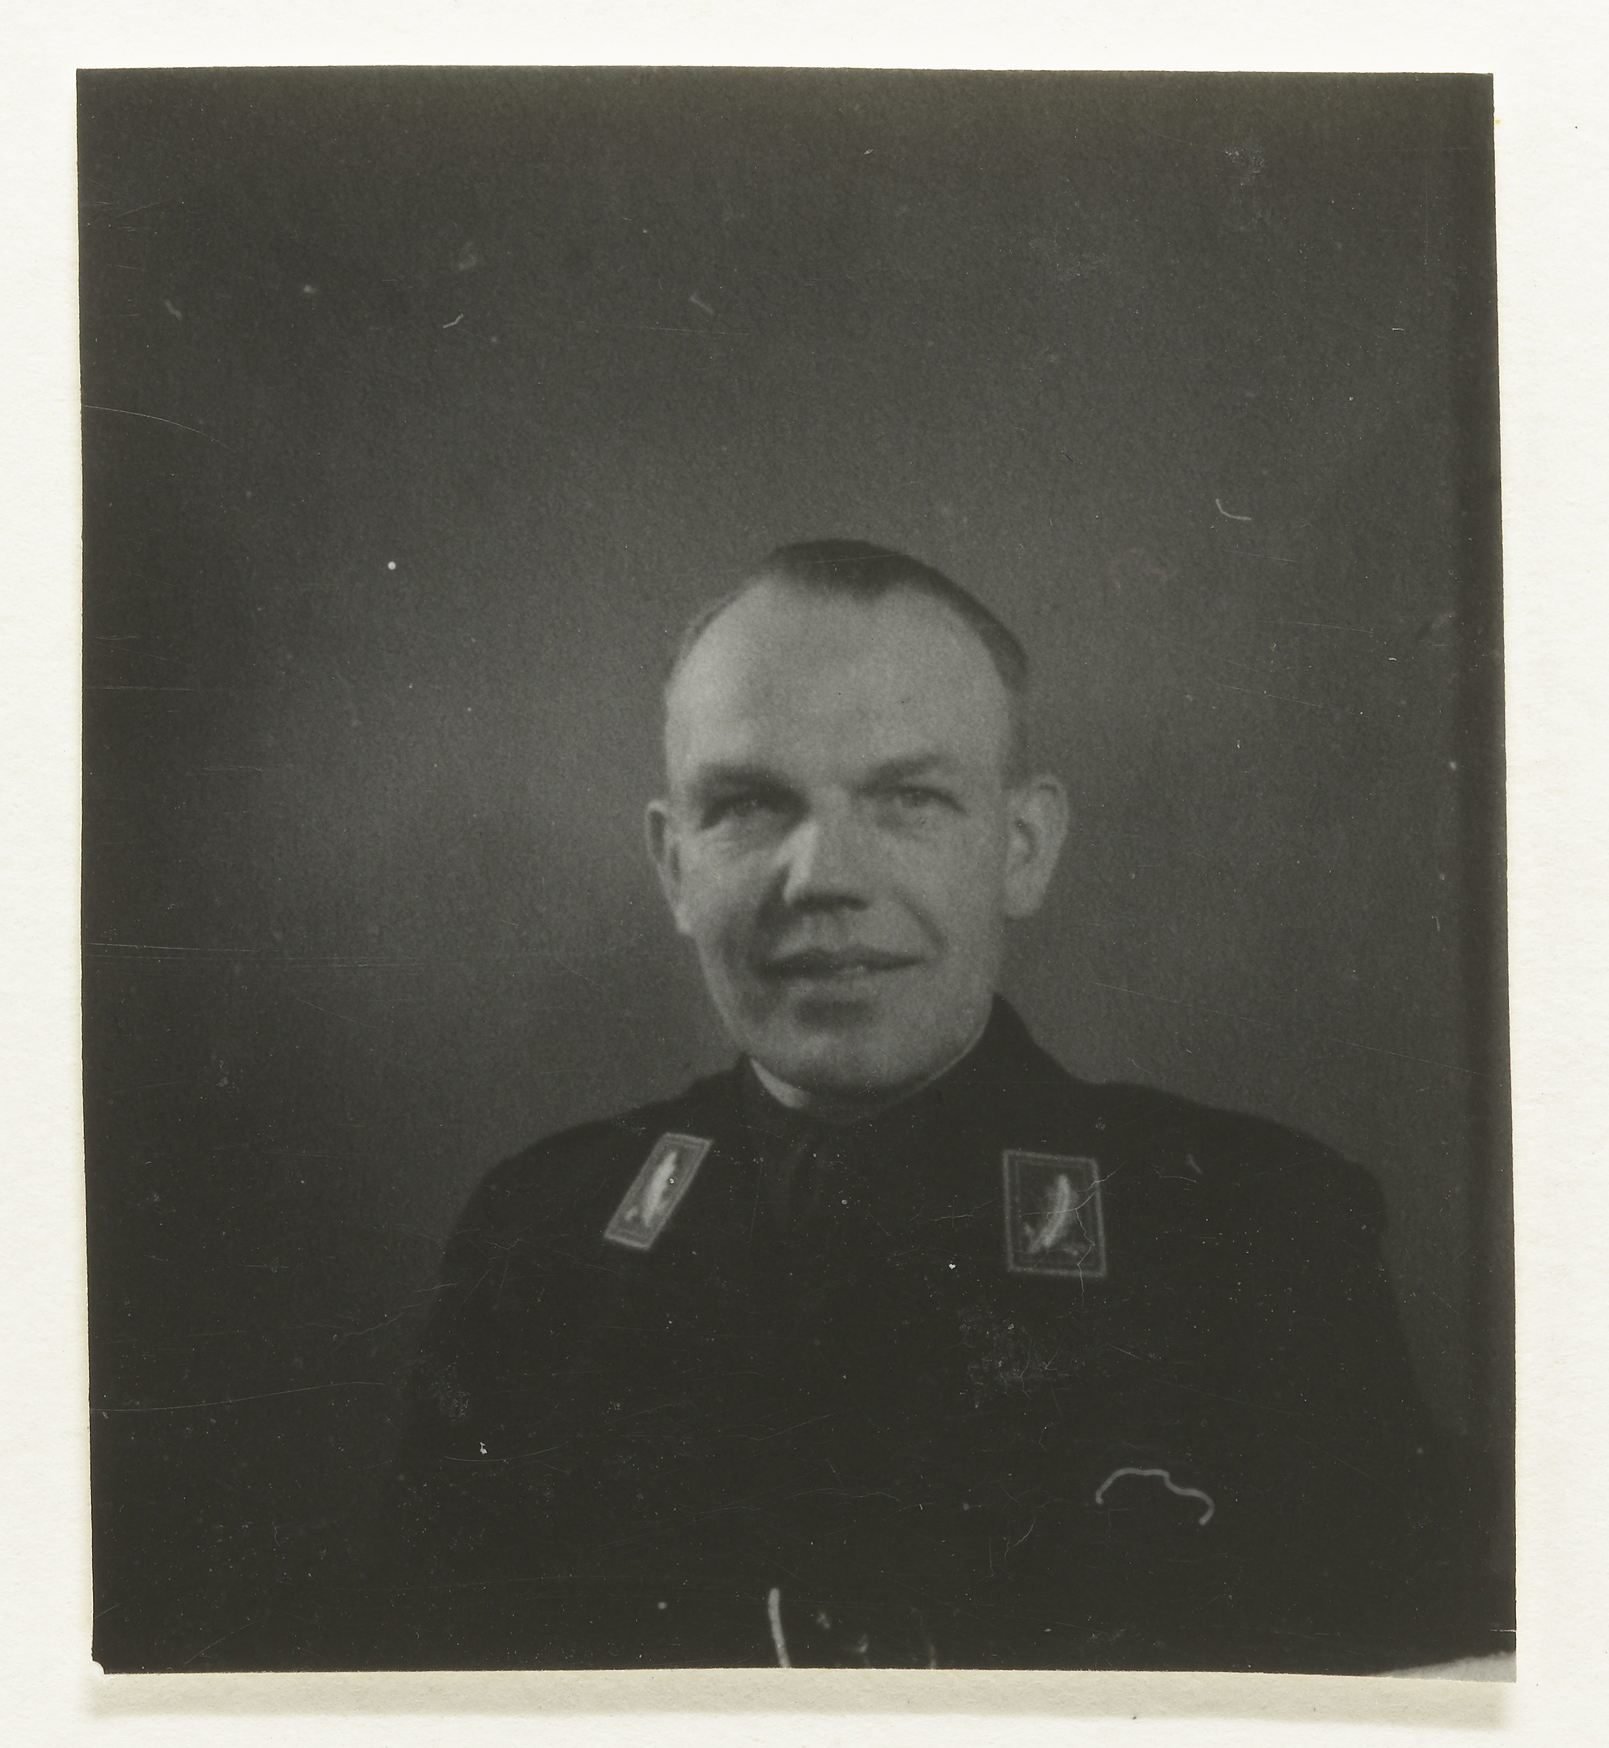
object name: contact print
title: NSB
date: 1940-1944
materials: photographic support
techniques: gelatin silver print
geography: netherlands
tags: mayor, burgomaster, historical persons, netherlands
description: Portret van een lid van de NSB, Wouter Roelof Jager, burgemeester van Enschede (op achterkant foto). Op zijn kraag een distinctief met een blad met nerven. Dit betekend een functie bij het hoofdwartier van de NSB, in dit geval Hoofd van Afdeeling. Man glimlacht, kijkt recht in de camera en is blootshoofd.